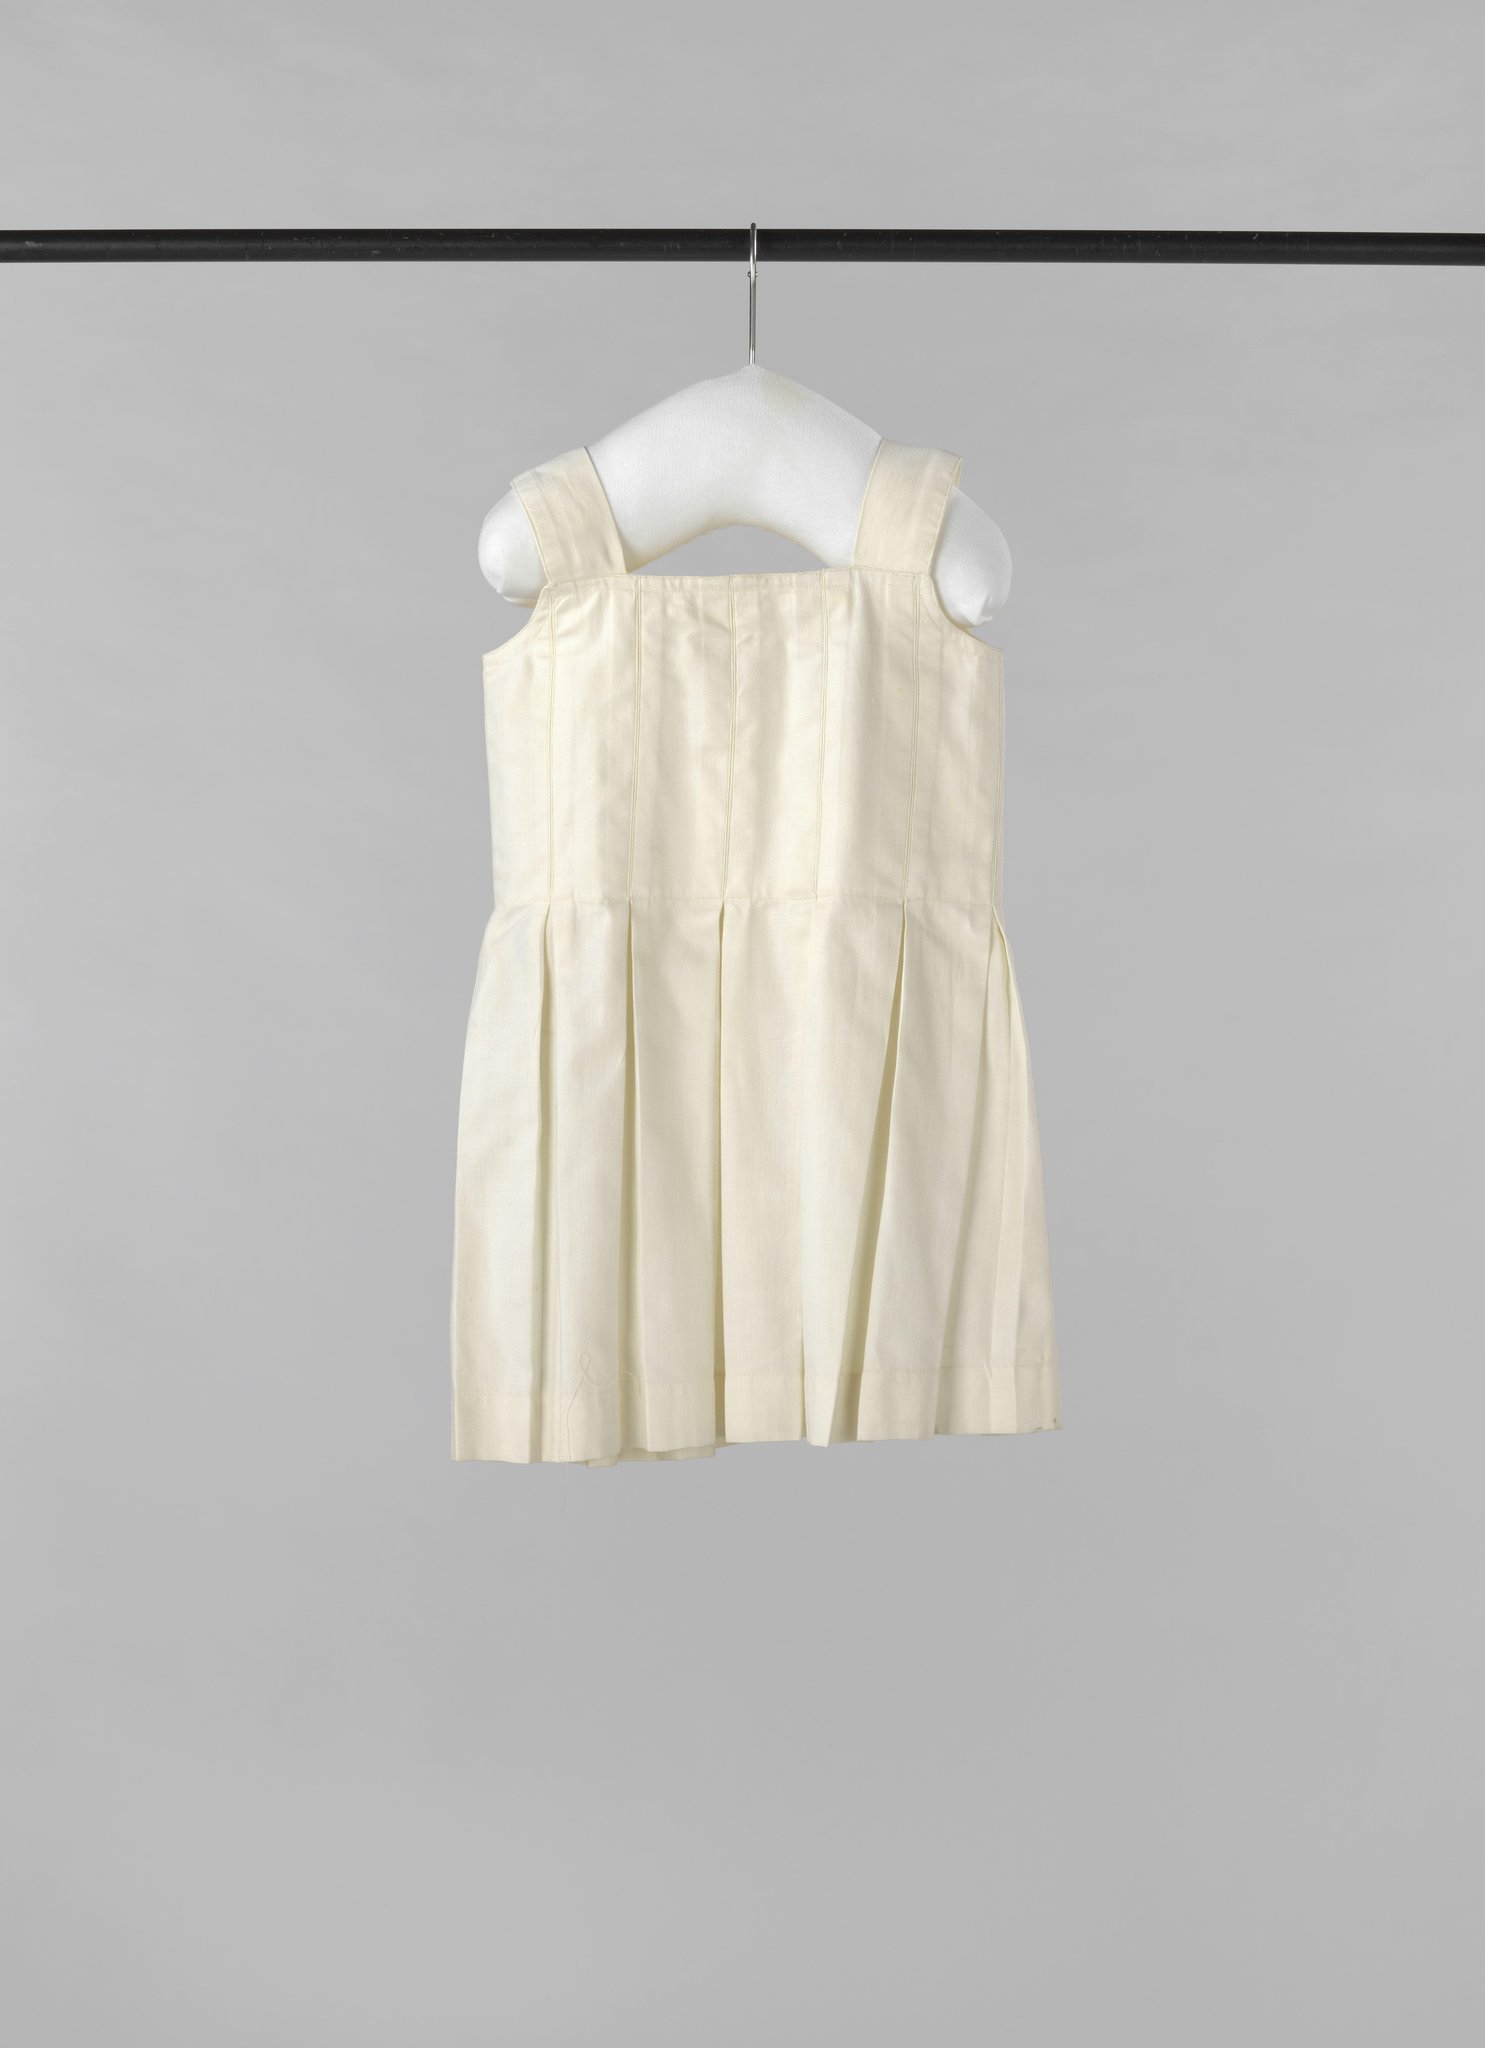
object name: main garment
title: Kinderjurk van stevige witte keperkatoen, met achtersplit met drie striklinten, brede schouderbanden en geplooide rok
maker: Anonymous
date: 1910-1930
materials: cotton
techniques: weave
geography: netherlands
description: Kinderjurk van stevige witte keperkatoen. Model: eenvoudig, met achtersplit met drie striklinten en met brede schouderbanden. Rok en lijf vormen één geheel: de plooien van de rok zijn op het lijfgedeelte dichtgestikt.